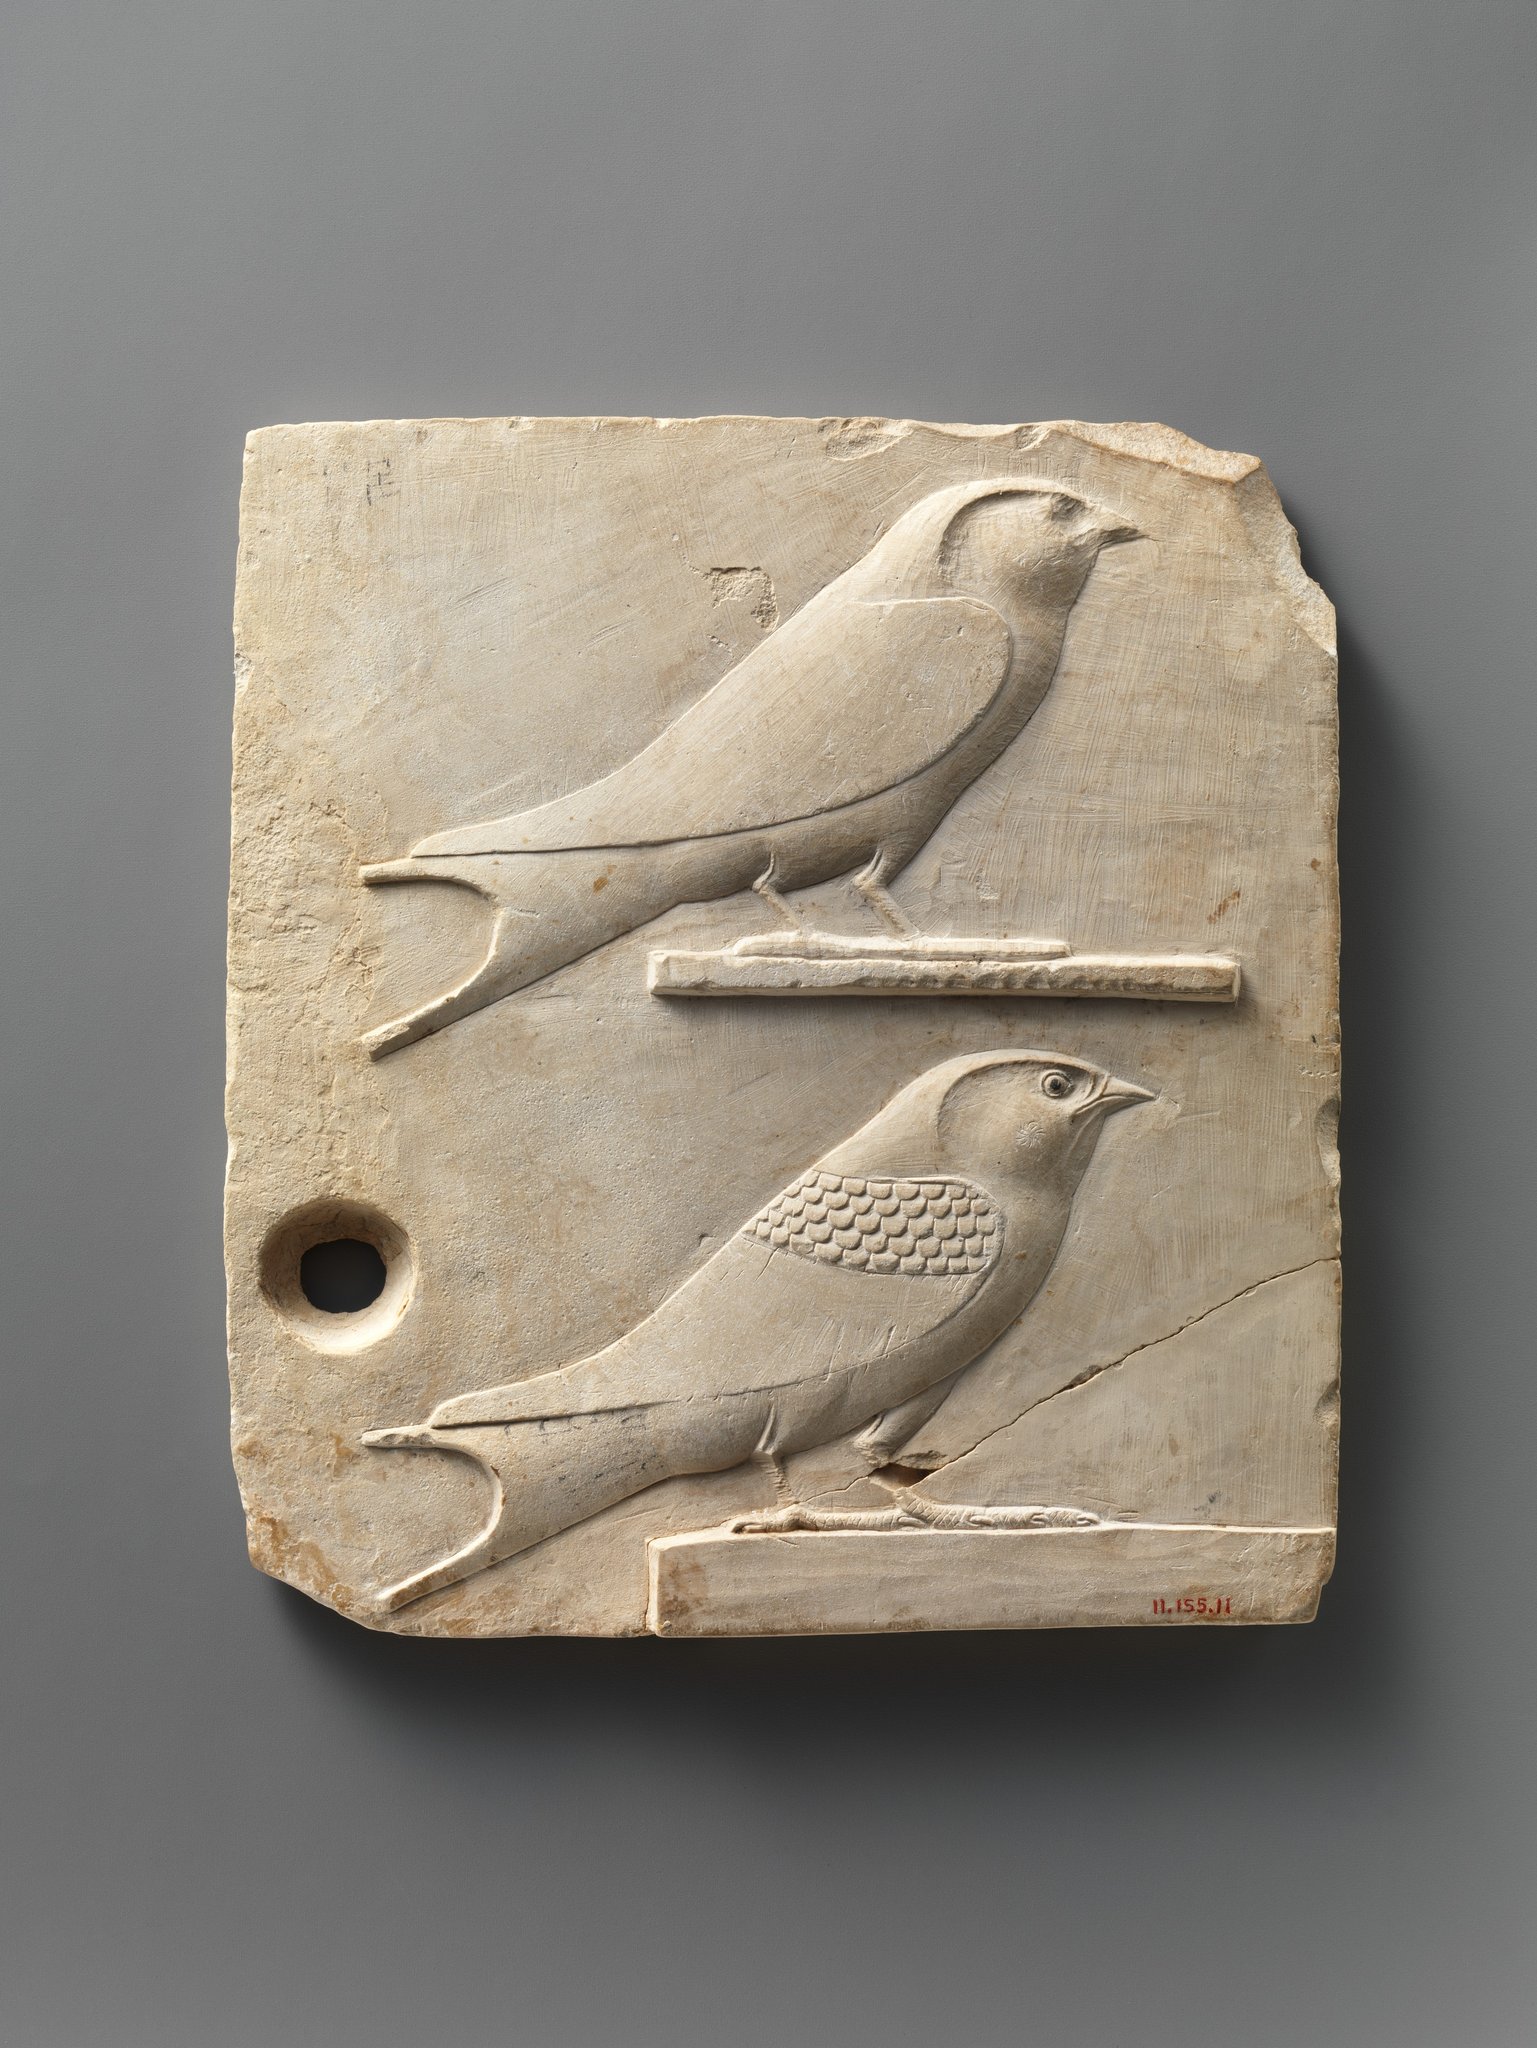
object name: sculptor's model votive, two swallow, two quail chick opposite side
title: Relief plaque with two swallows, opposite side two quail chicks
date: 400-30 BCE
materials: limestone, paint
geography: egypt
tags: birds